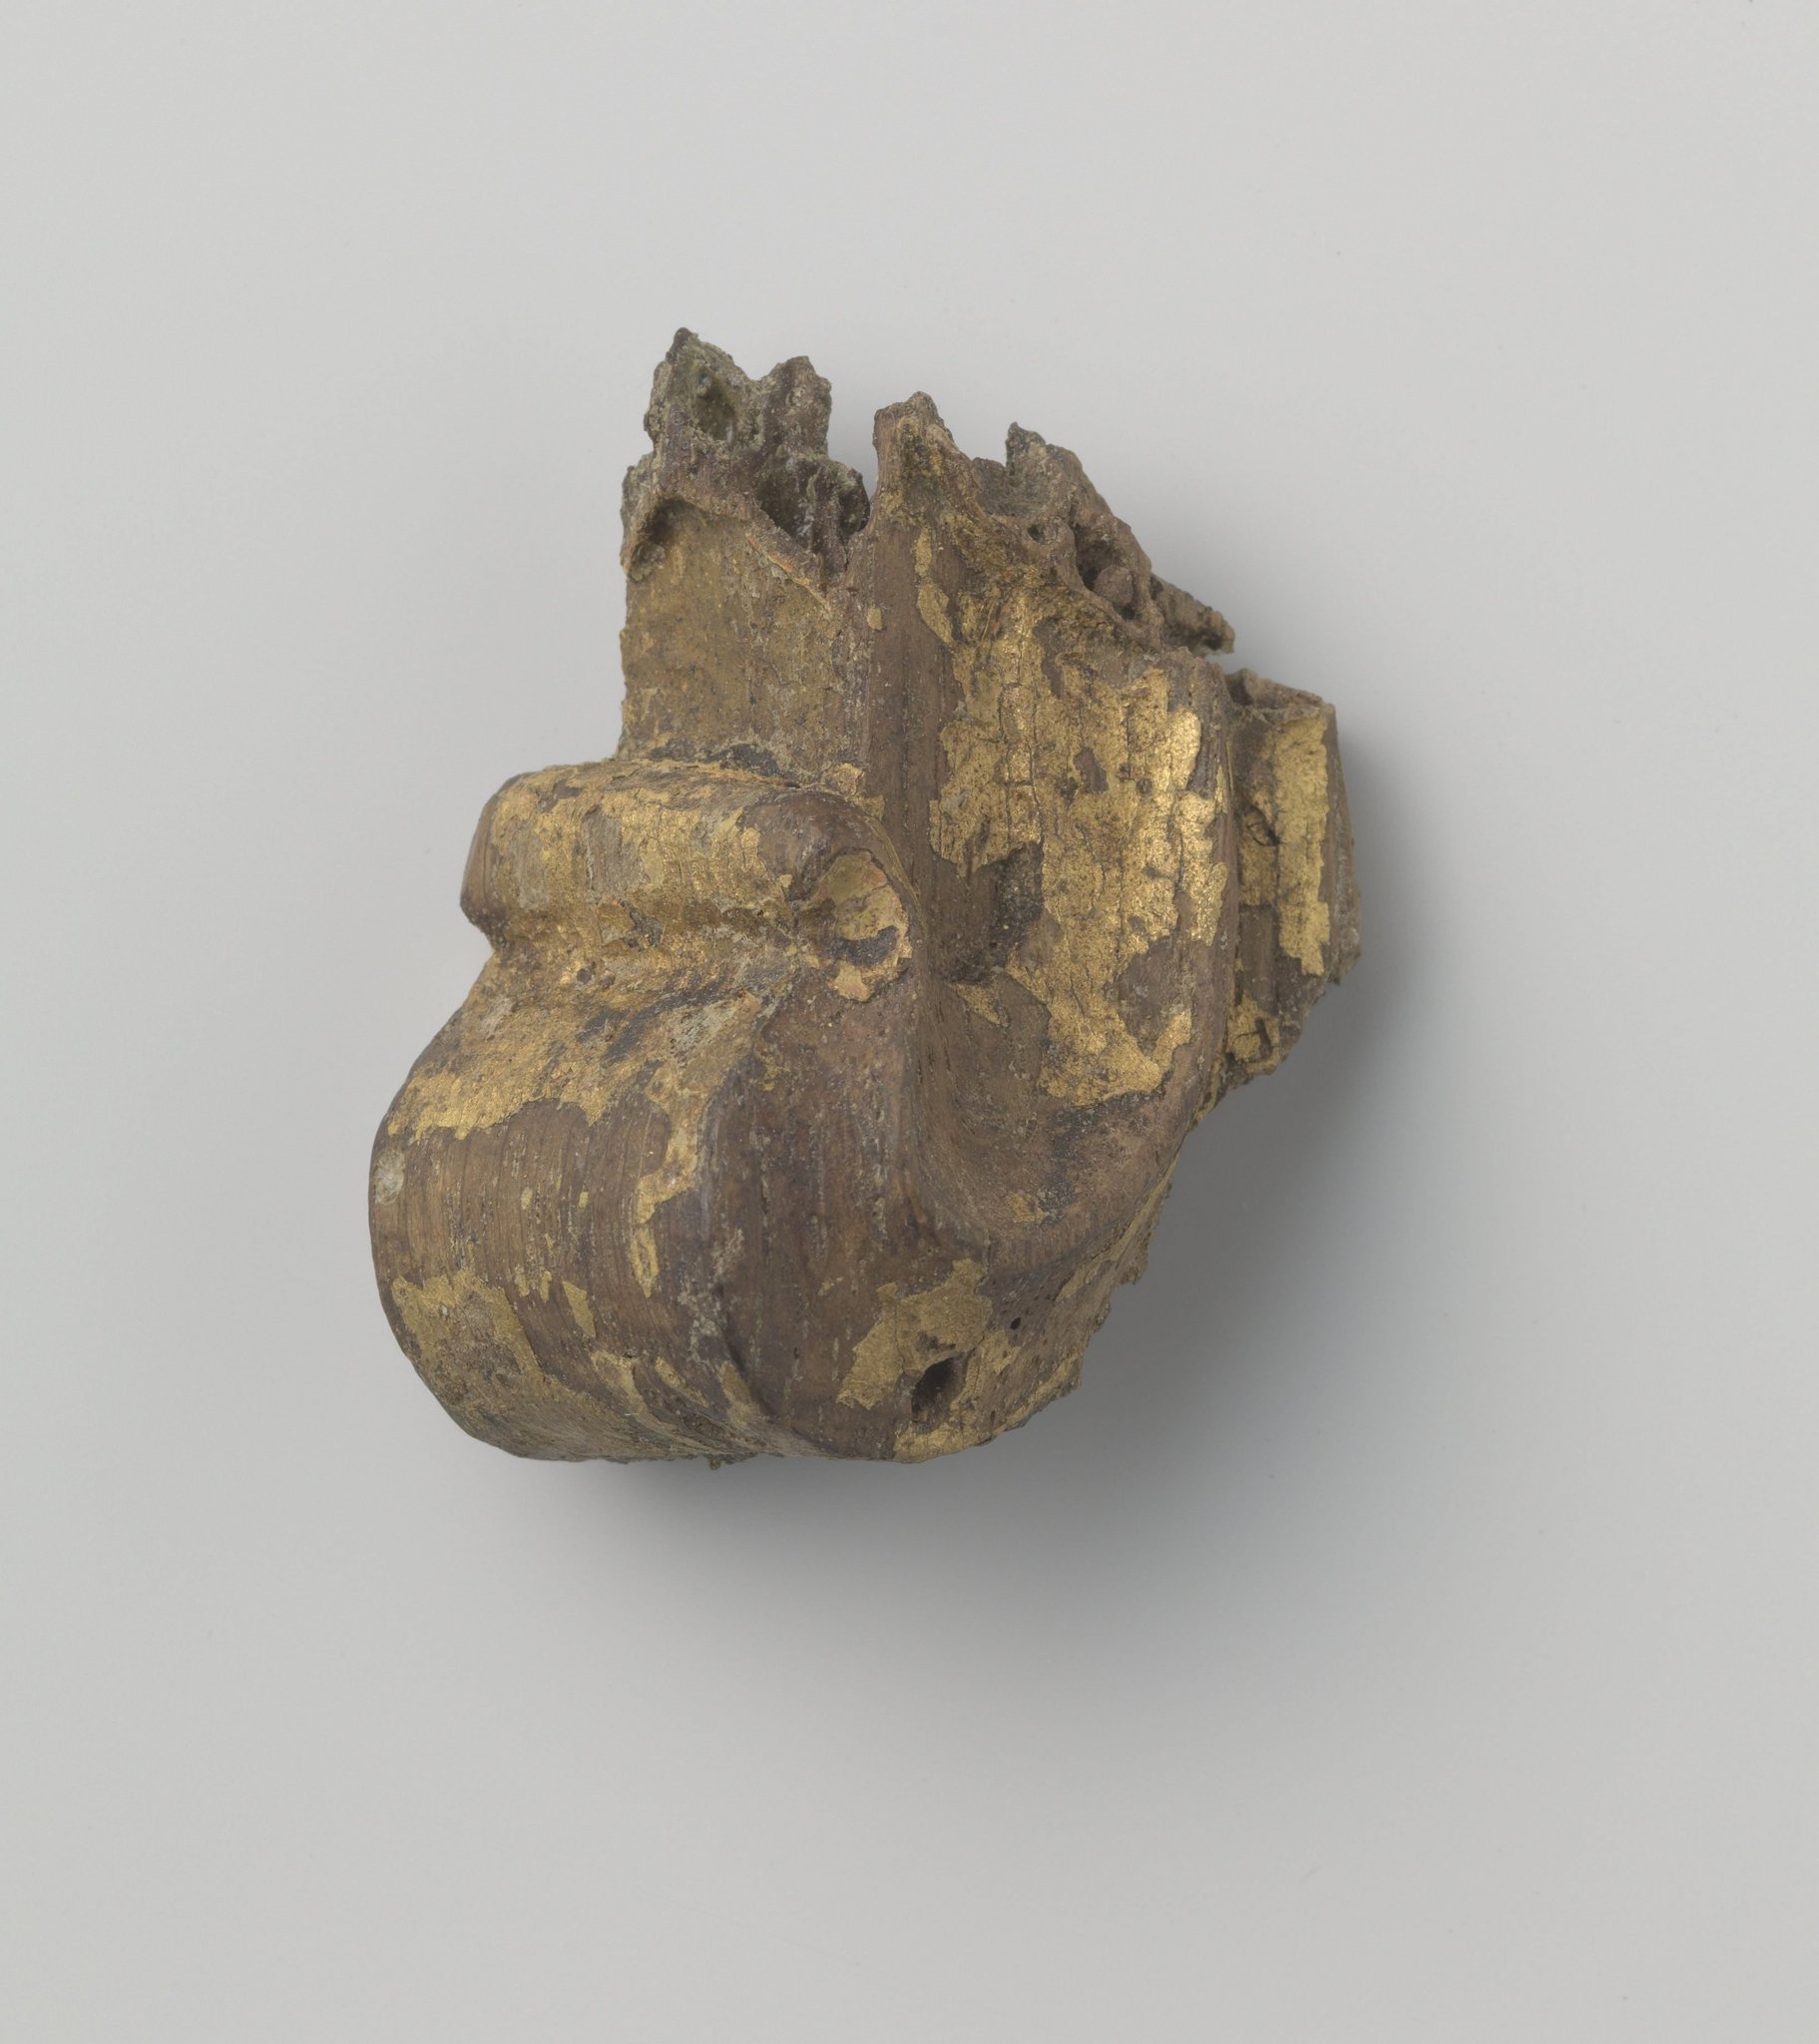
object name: fragment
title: Fragment; (mogelijk) behorend tot het retabel van Soest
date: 1475-1499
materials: wood